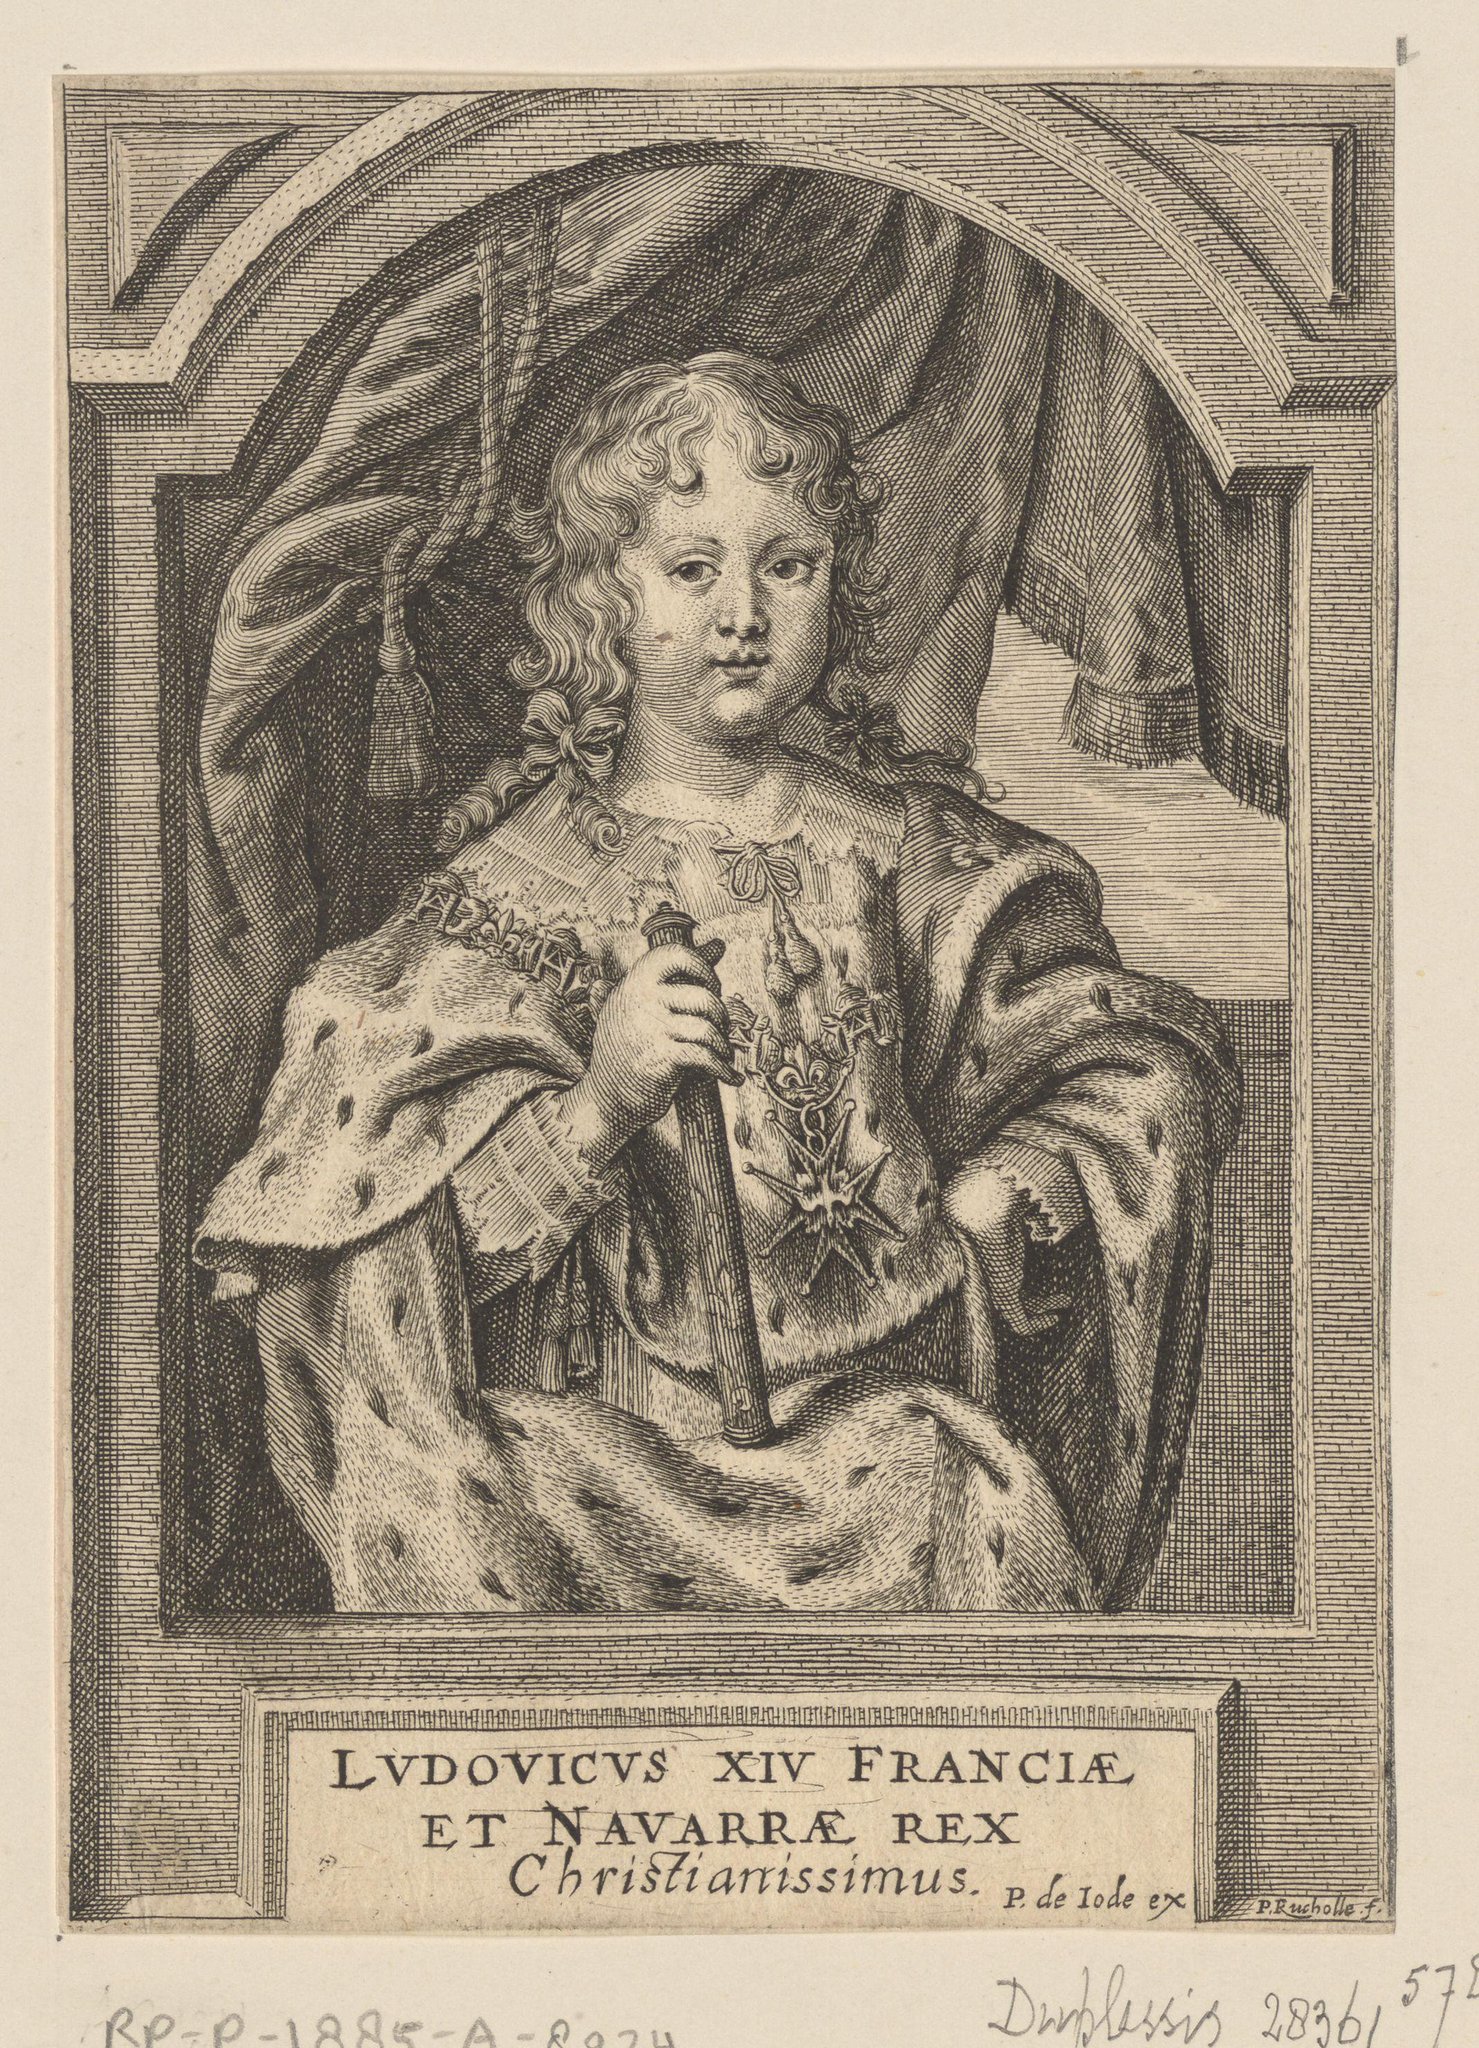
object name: print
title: Portret van Lodewijk XIV van Frankrijk als kind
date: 1643-1647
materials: paper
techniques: engraving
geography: antwerp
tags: lodewijk xiv (koning van frankrijk), historical persons, king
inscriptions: collector's mark: Lugt 2228